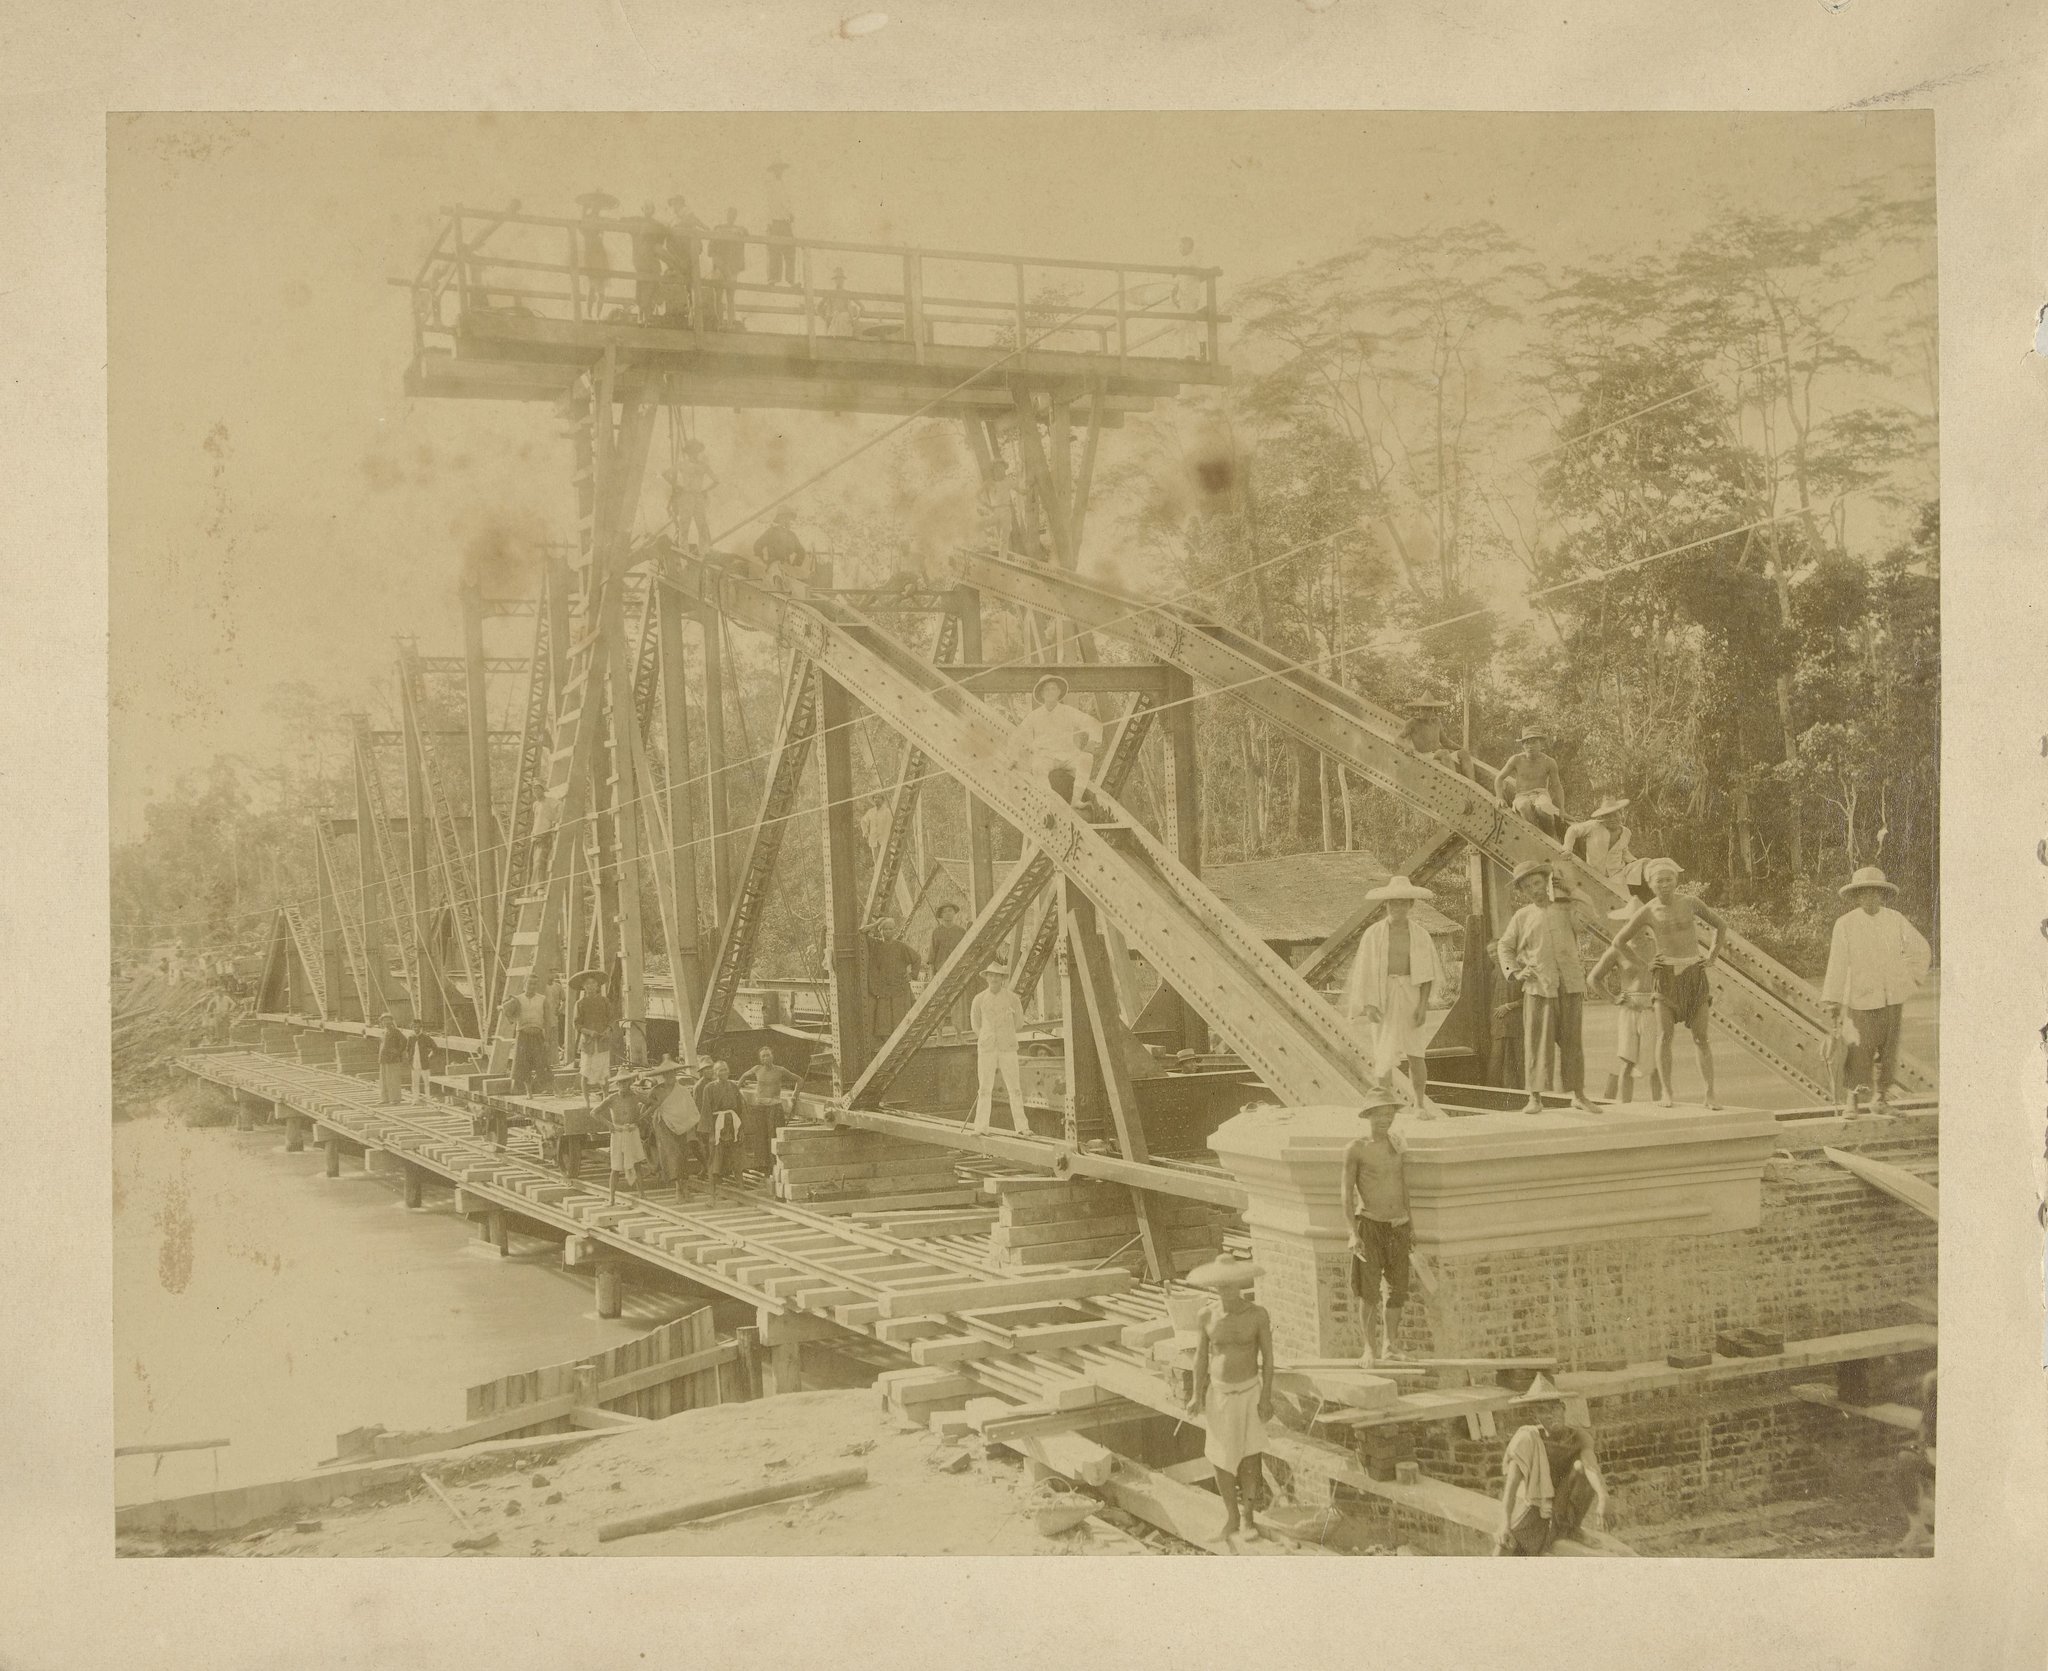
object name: photograph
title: Contractarbeiders en Europeanen bij een spoorwegbrug in aanbouw, Nederlands-Indië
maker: Anonymous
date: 1870-1900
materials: cardboard, paper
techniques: albumen print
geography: dutch east indies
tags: bridge, building-site, dutch east indies, the